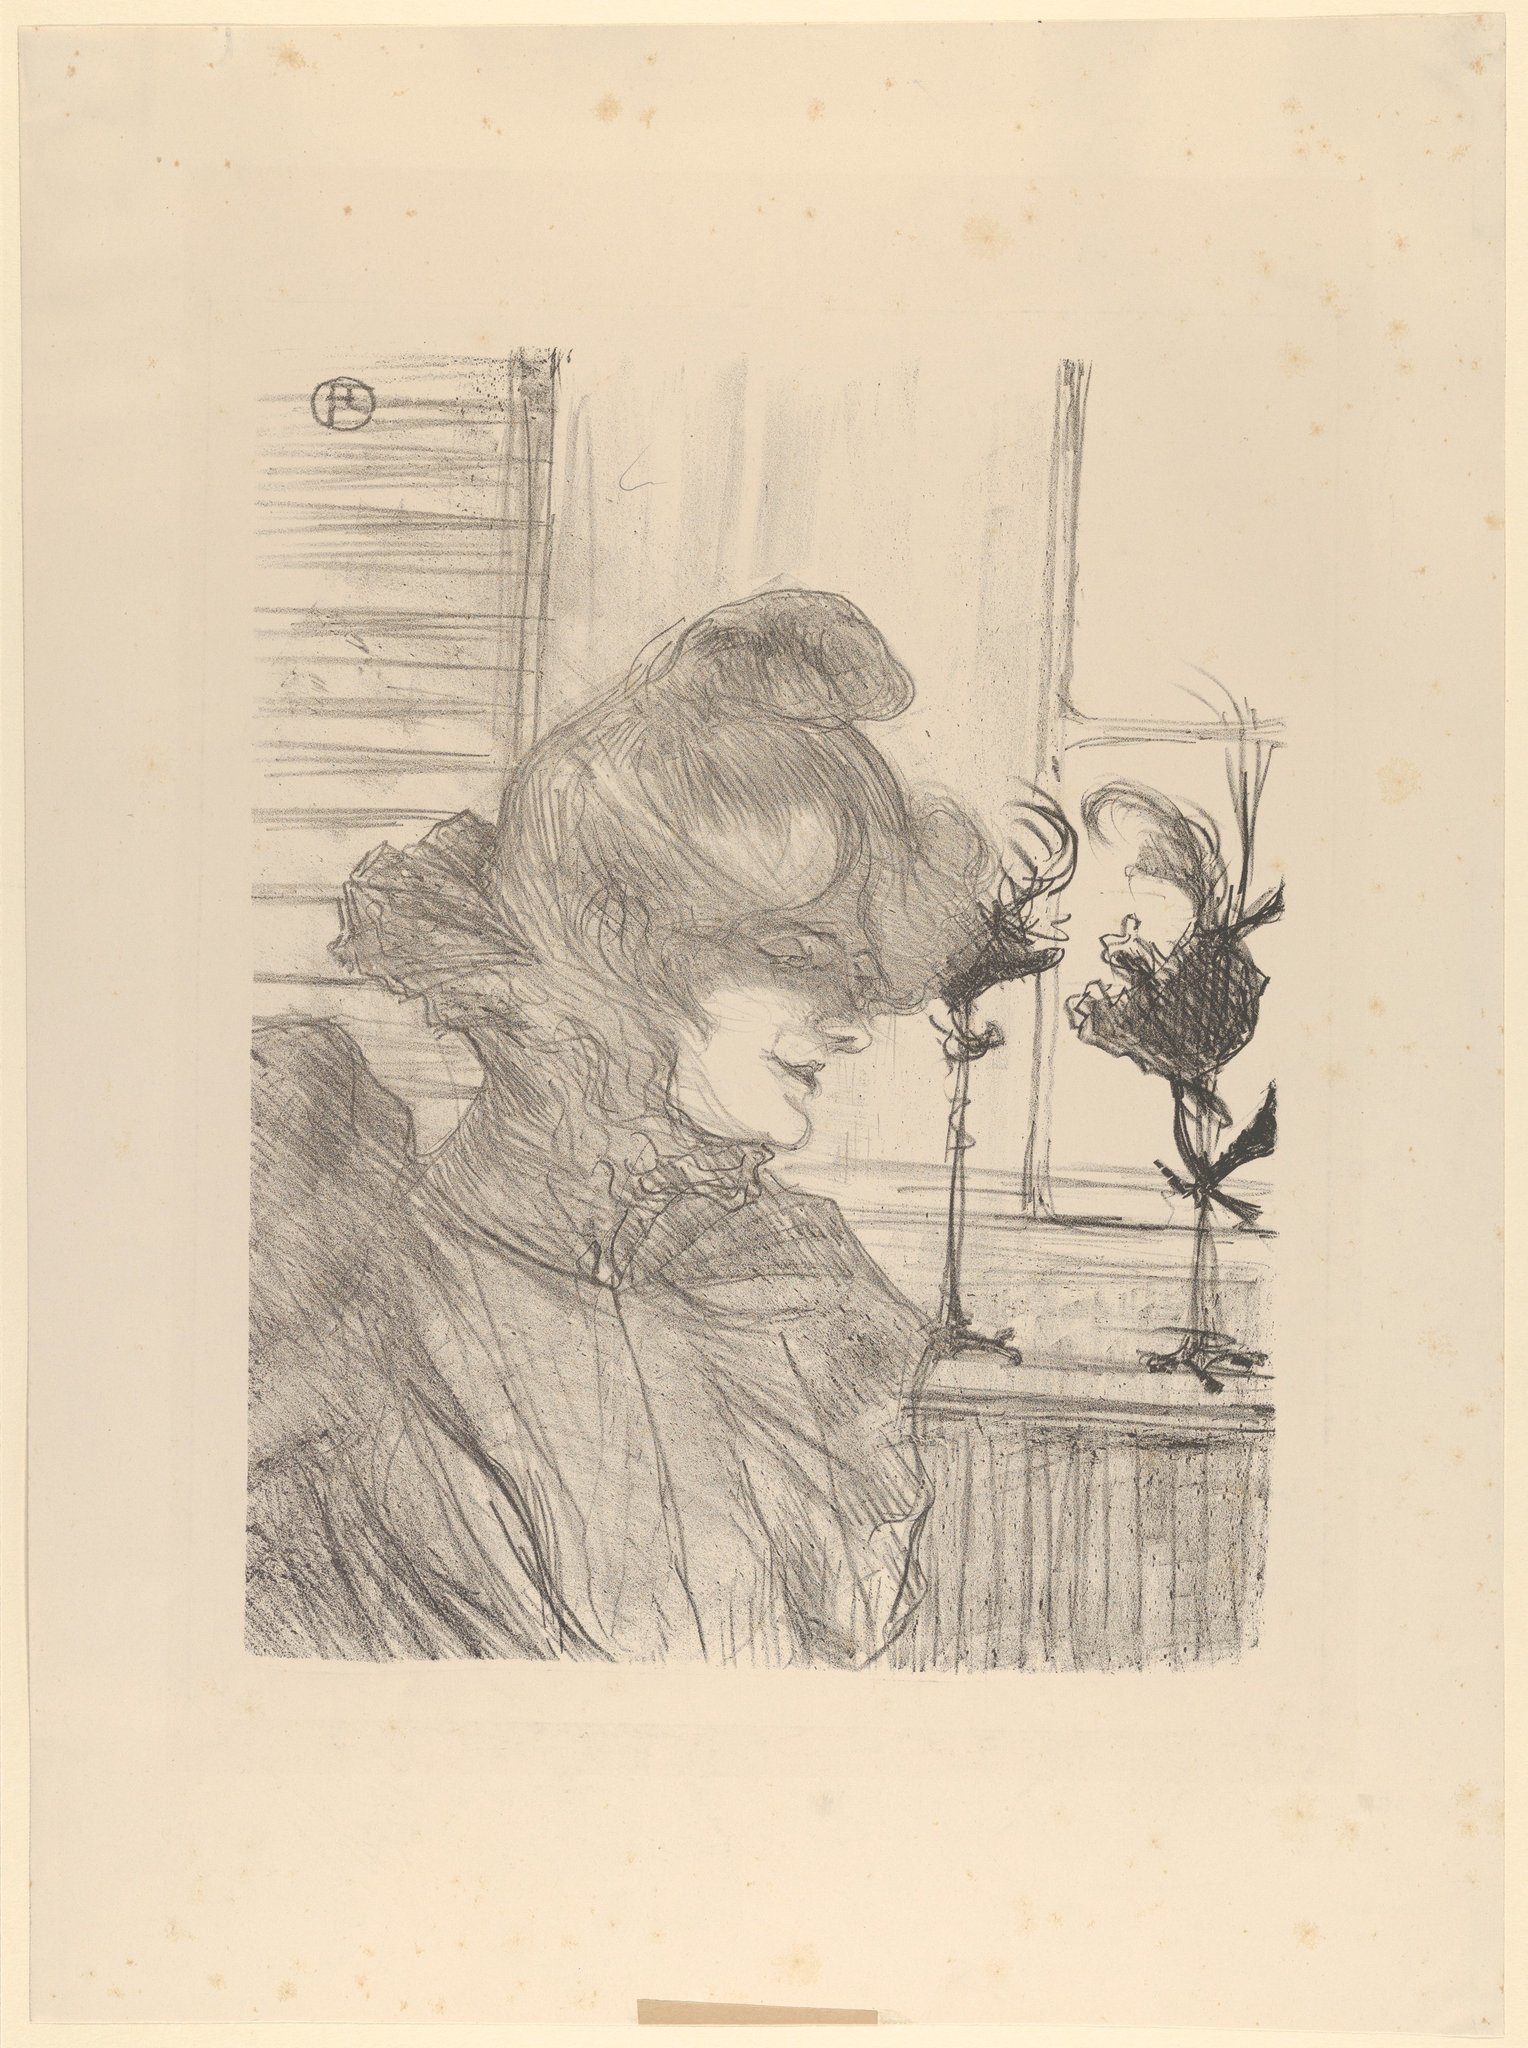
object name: print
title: Louise Blouet "Le Margoin"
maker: henri de toulouse-lautrec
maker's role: artist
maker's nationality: french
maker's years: 1864-1901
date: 1900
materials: parchment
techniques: lithograph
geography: france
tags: profiles,women